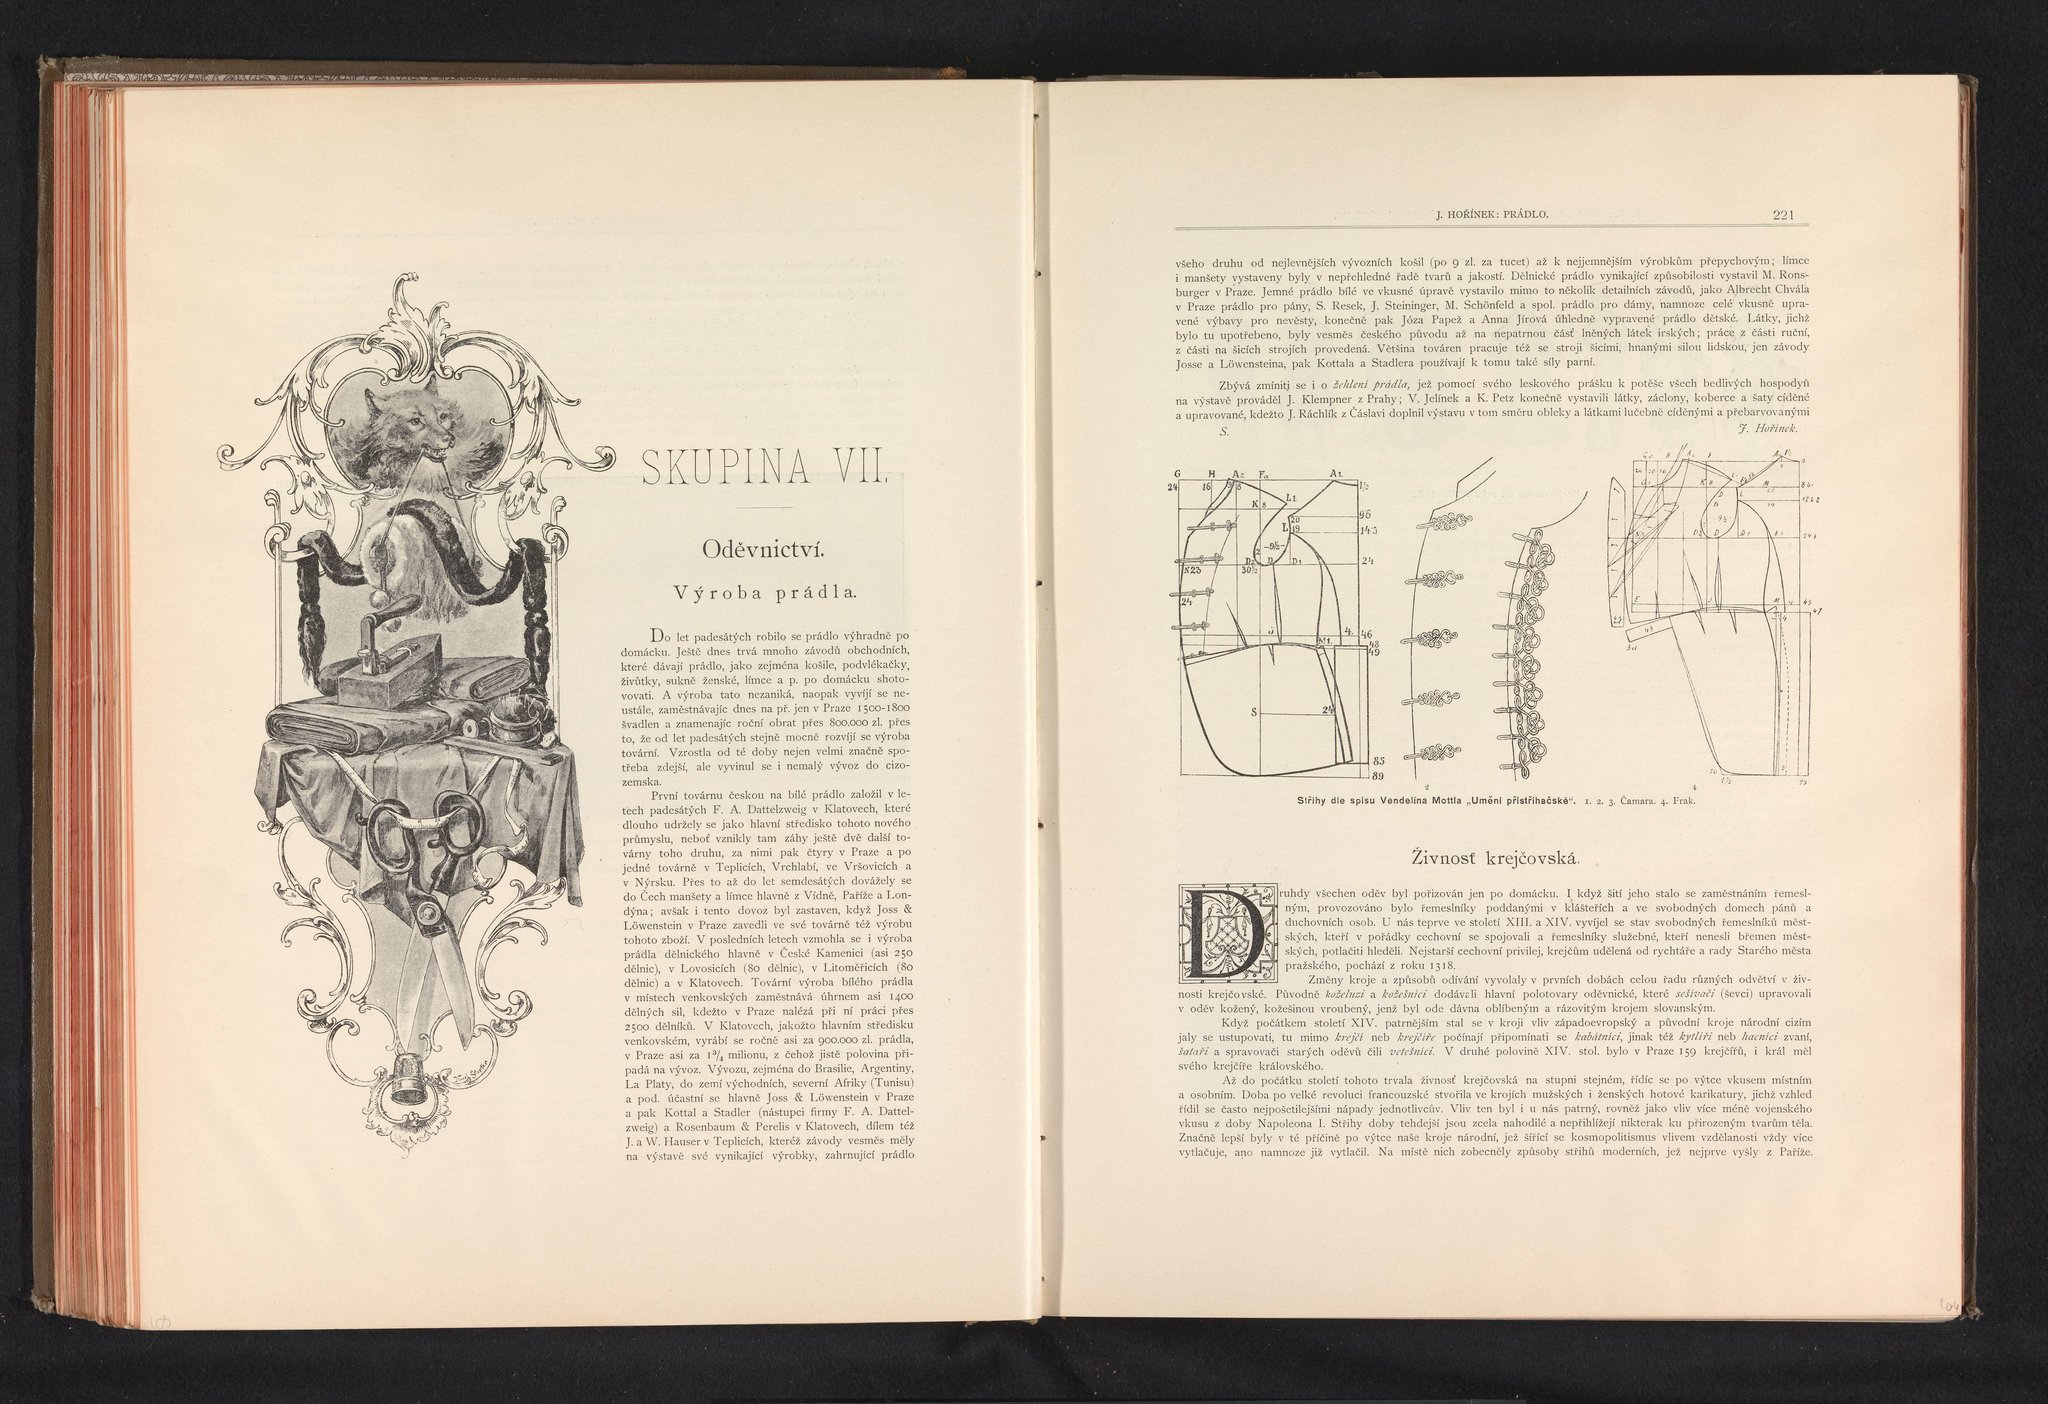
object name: photomechanical print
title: Fotoreproductie van een tekening, voorstellende een tafel met gereedschappen voor het maken van kleding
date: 1890-1895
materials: paper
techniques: autotype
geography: prague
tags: tools, aids, implements ~ crafts and industries, table, tools, aids, implements ~ crafts and industries: scissors